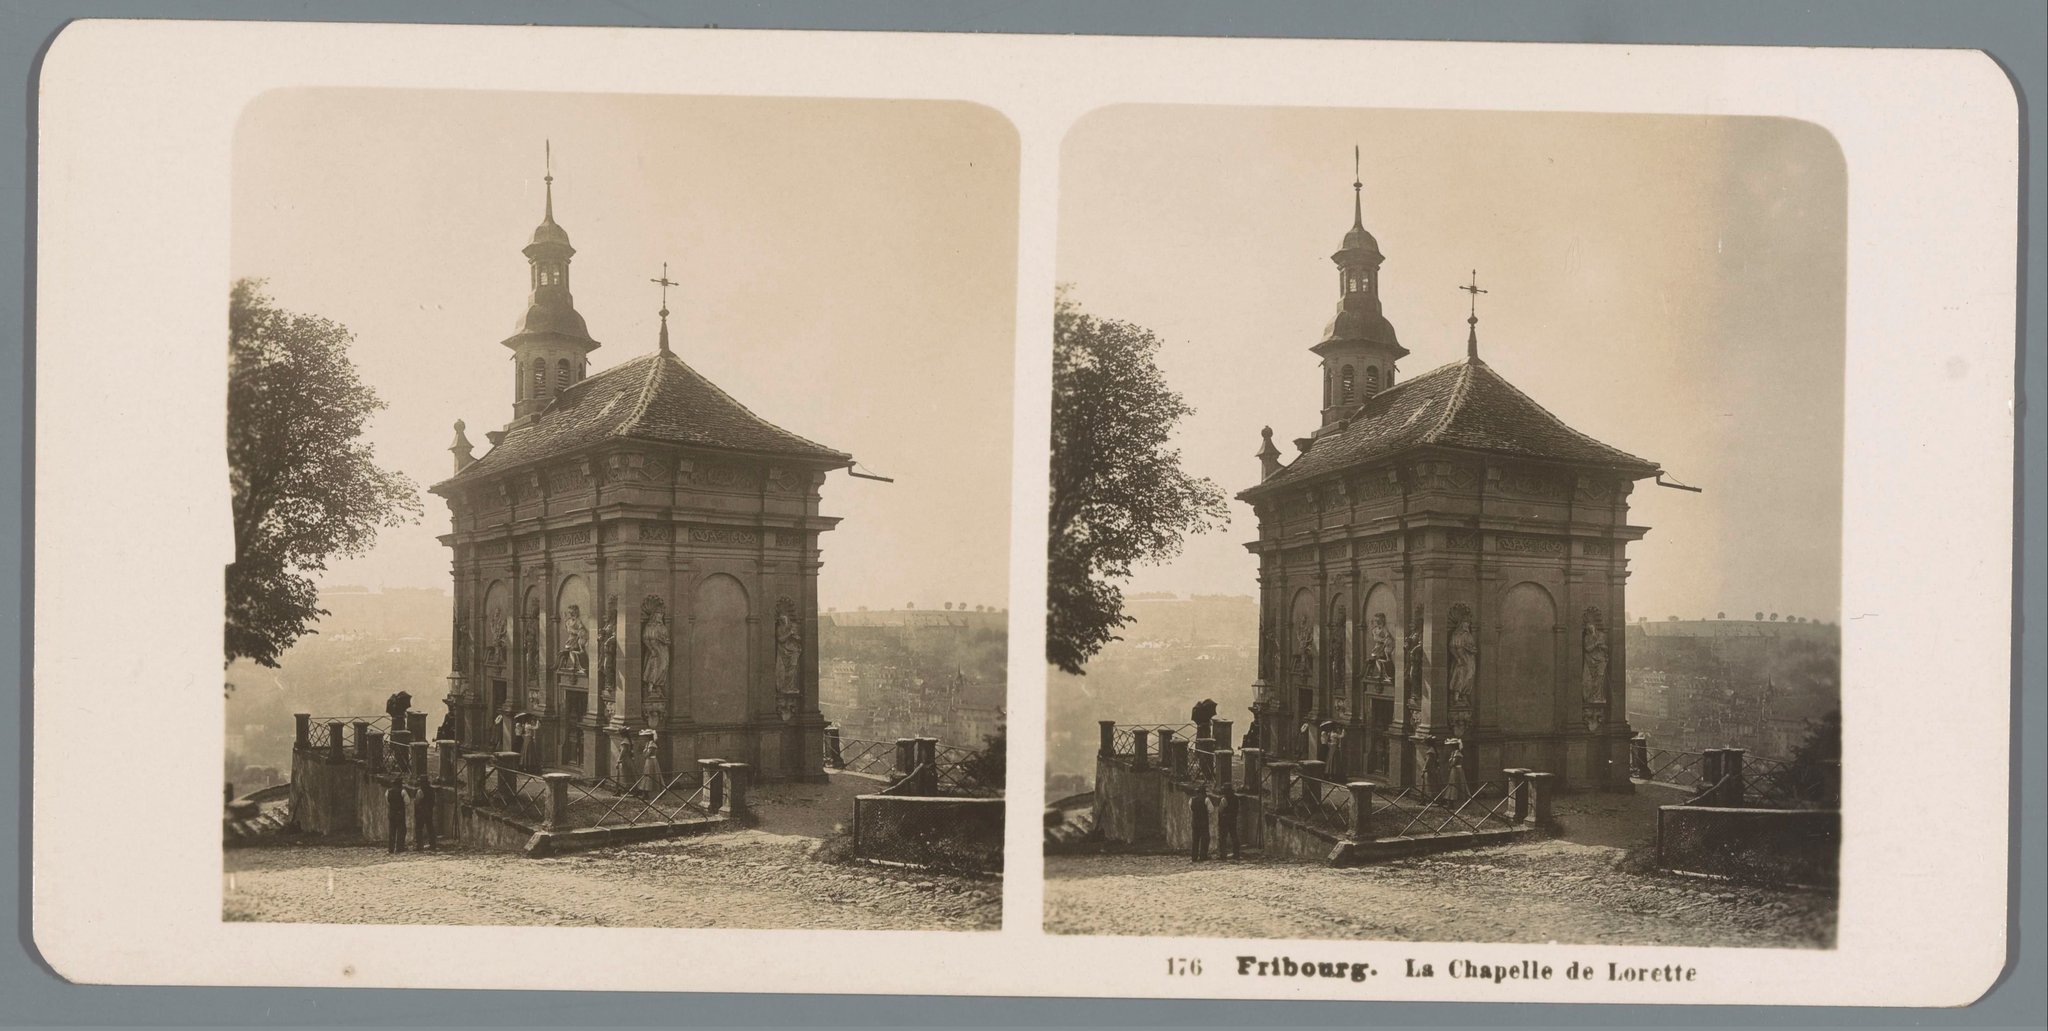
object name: stereograph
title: Fribourg. La Chapelle de Lorette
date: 1906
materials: cardboard, photographic support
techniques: gelatin silver print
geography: fribourg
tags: church (exterior) - qq - small church, chapel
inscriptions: inscription: ‘Neue Photographische Gesellschaft A. G., Steglitz-Berlin 1906.’, number: ‘176’